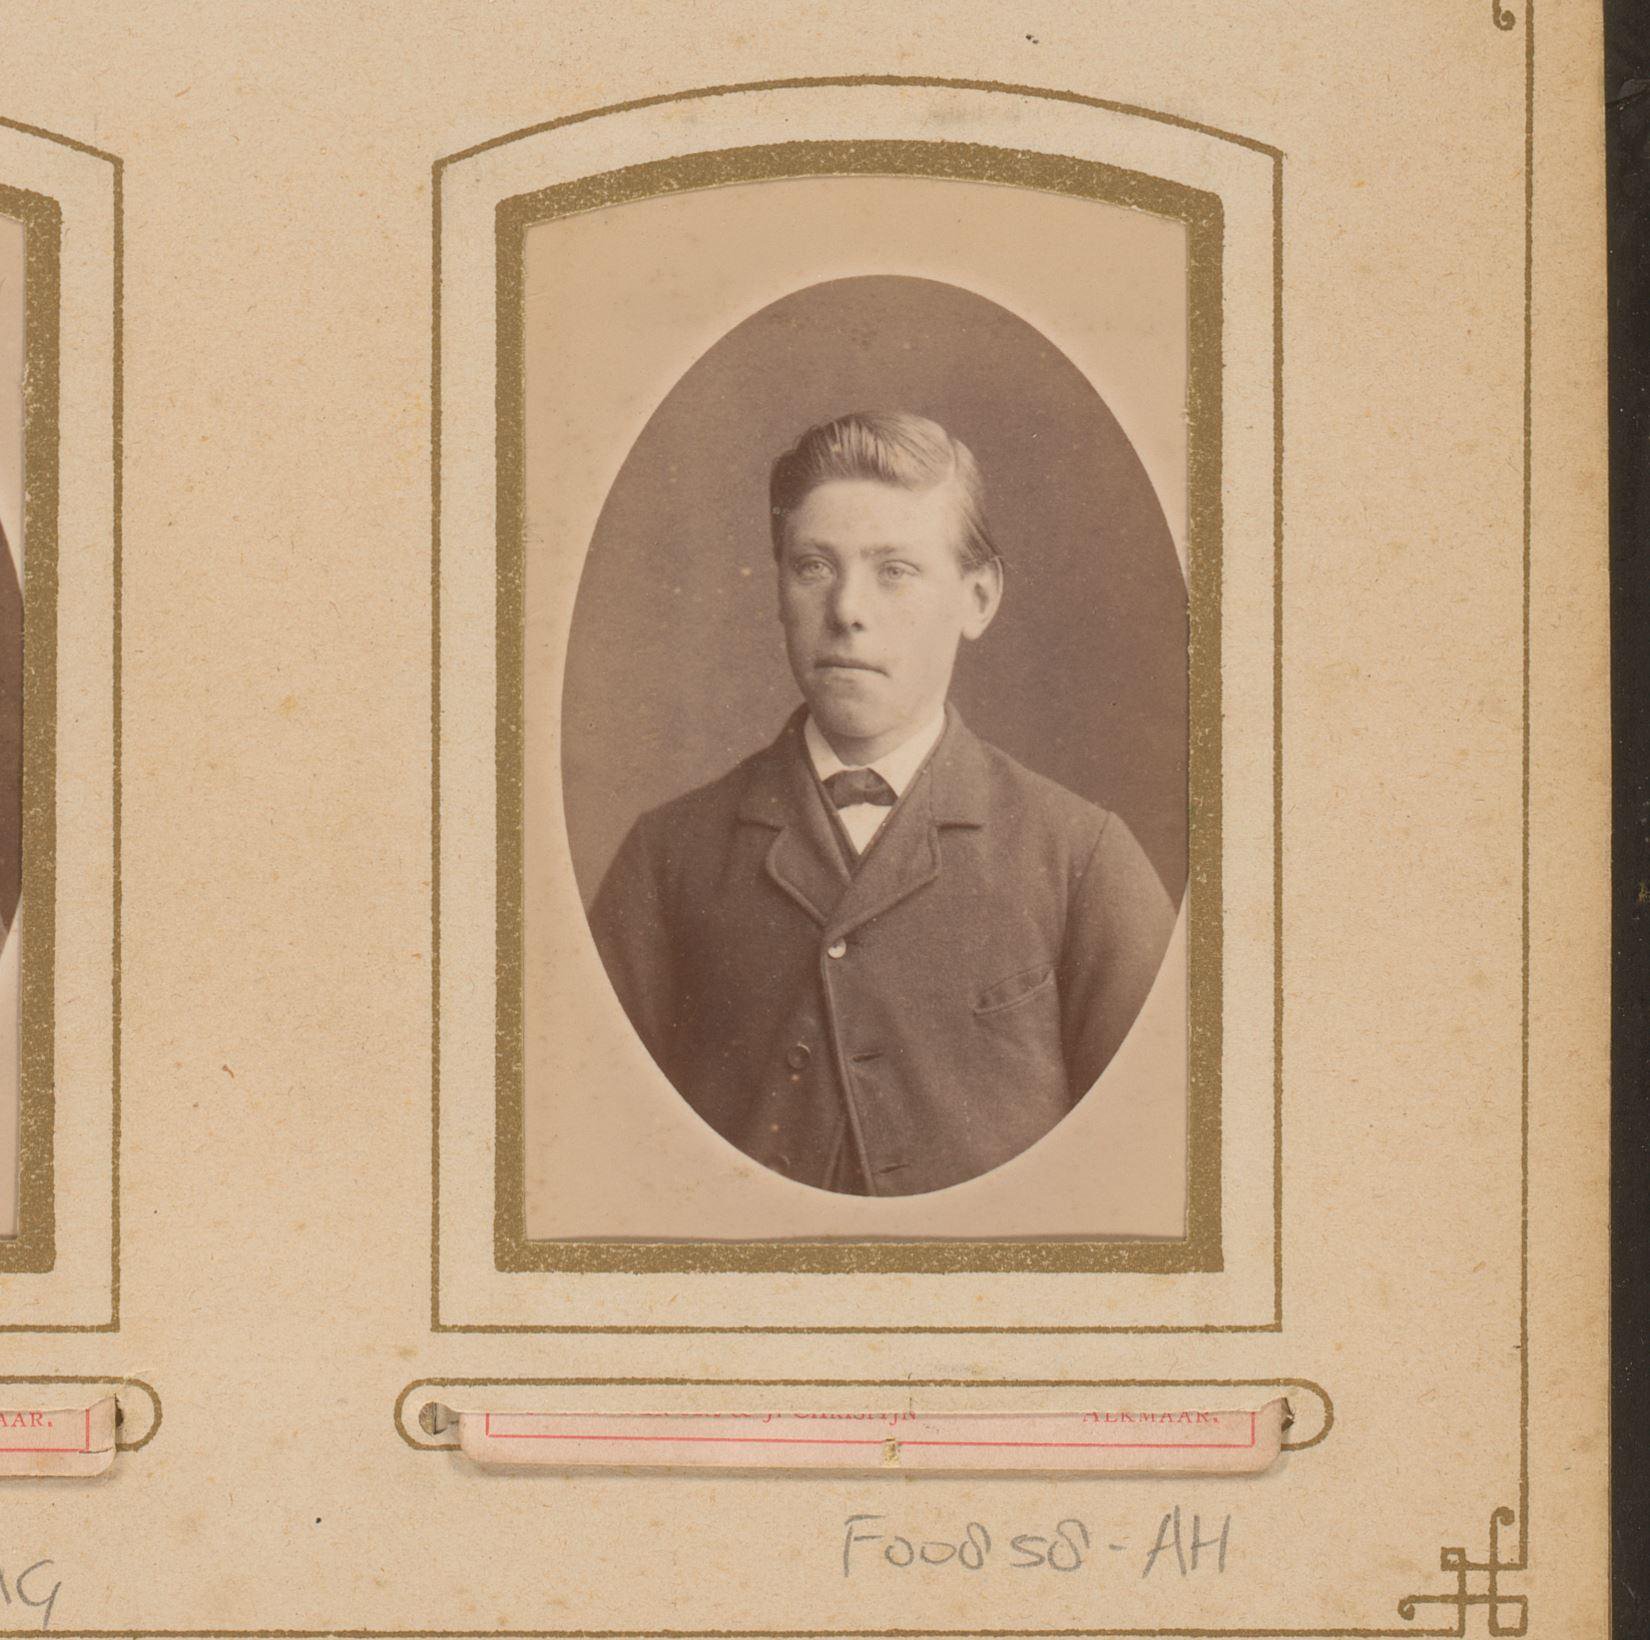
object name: album leaf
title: Portret van een jongeman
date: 1884-1895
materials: cardboard, photographic support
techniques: albumen print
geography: north holland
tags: historical persons, youth, adolescent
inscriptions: inscription: ‘Alkmaar, Verdronken Oord; Helder, Kanaalweg 99’